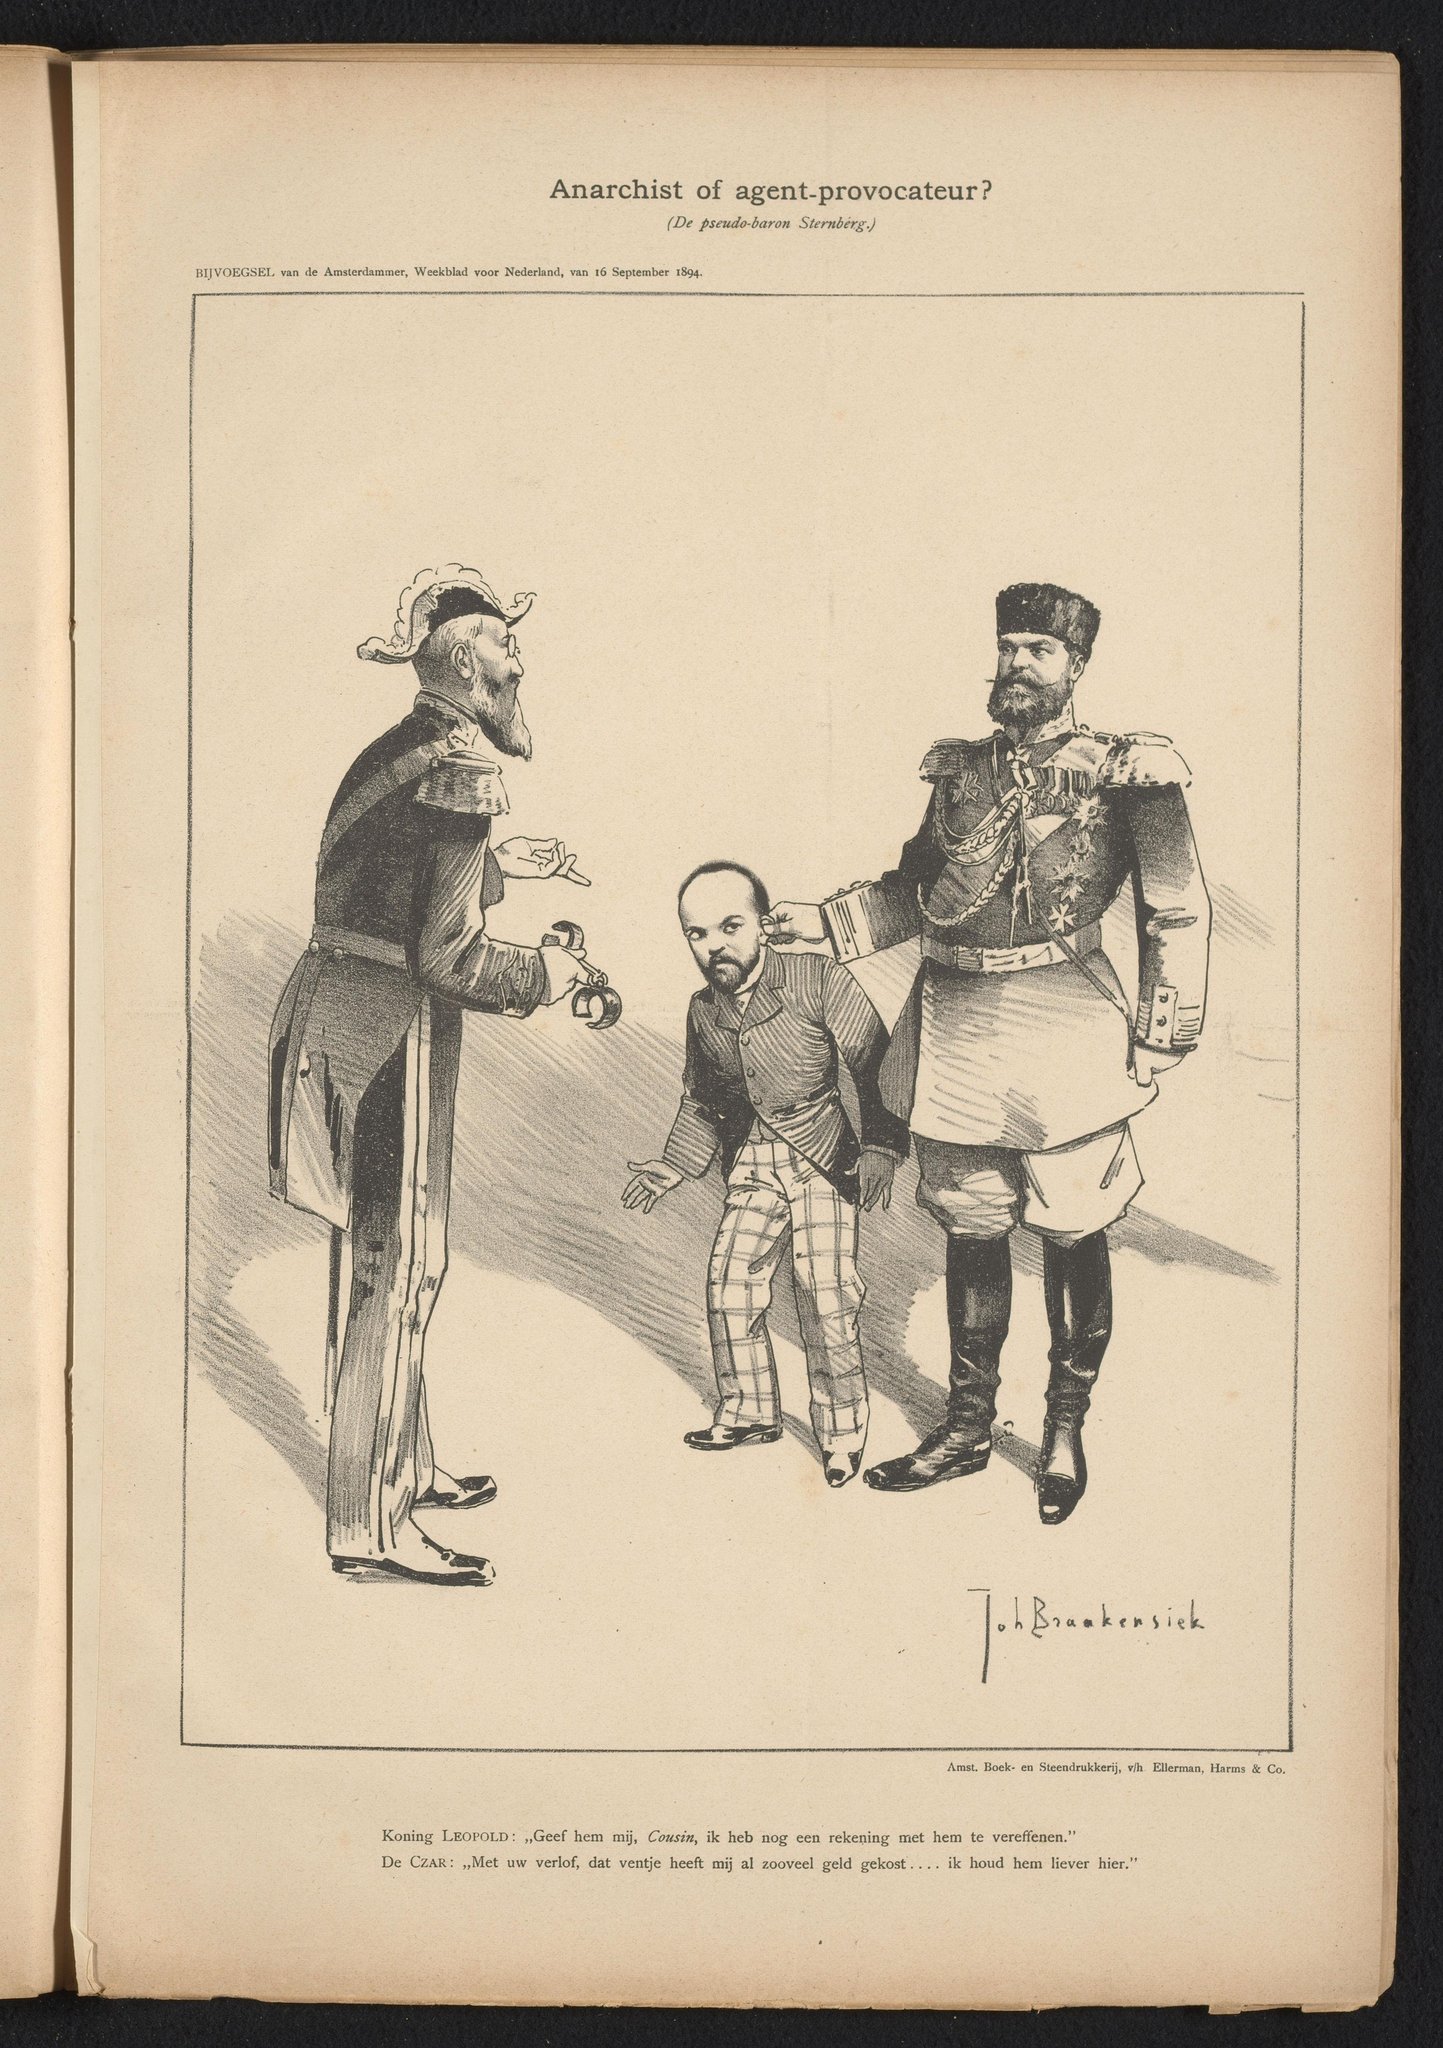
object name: cartoon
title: Anarchist of agent-provocateur? (De pseudo-baron Sternberg)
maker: johan braakensiek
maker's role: draughtsman, print maker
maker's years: 1858-1940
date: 1894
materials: paper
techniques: lithograph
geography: netherlands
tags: leopold ii (koning der belgen), political caricatures and satires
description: De Belgische koning Leopold II wil de gevangene, de 'pseudo-baron Sternberg', die de Russische tsaar Alexander III als een kwajongen bij de oor houdt, graag van hem over nemen.